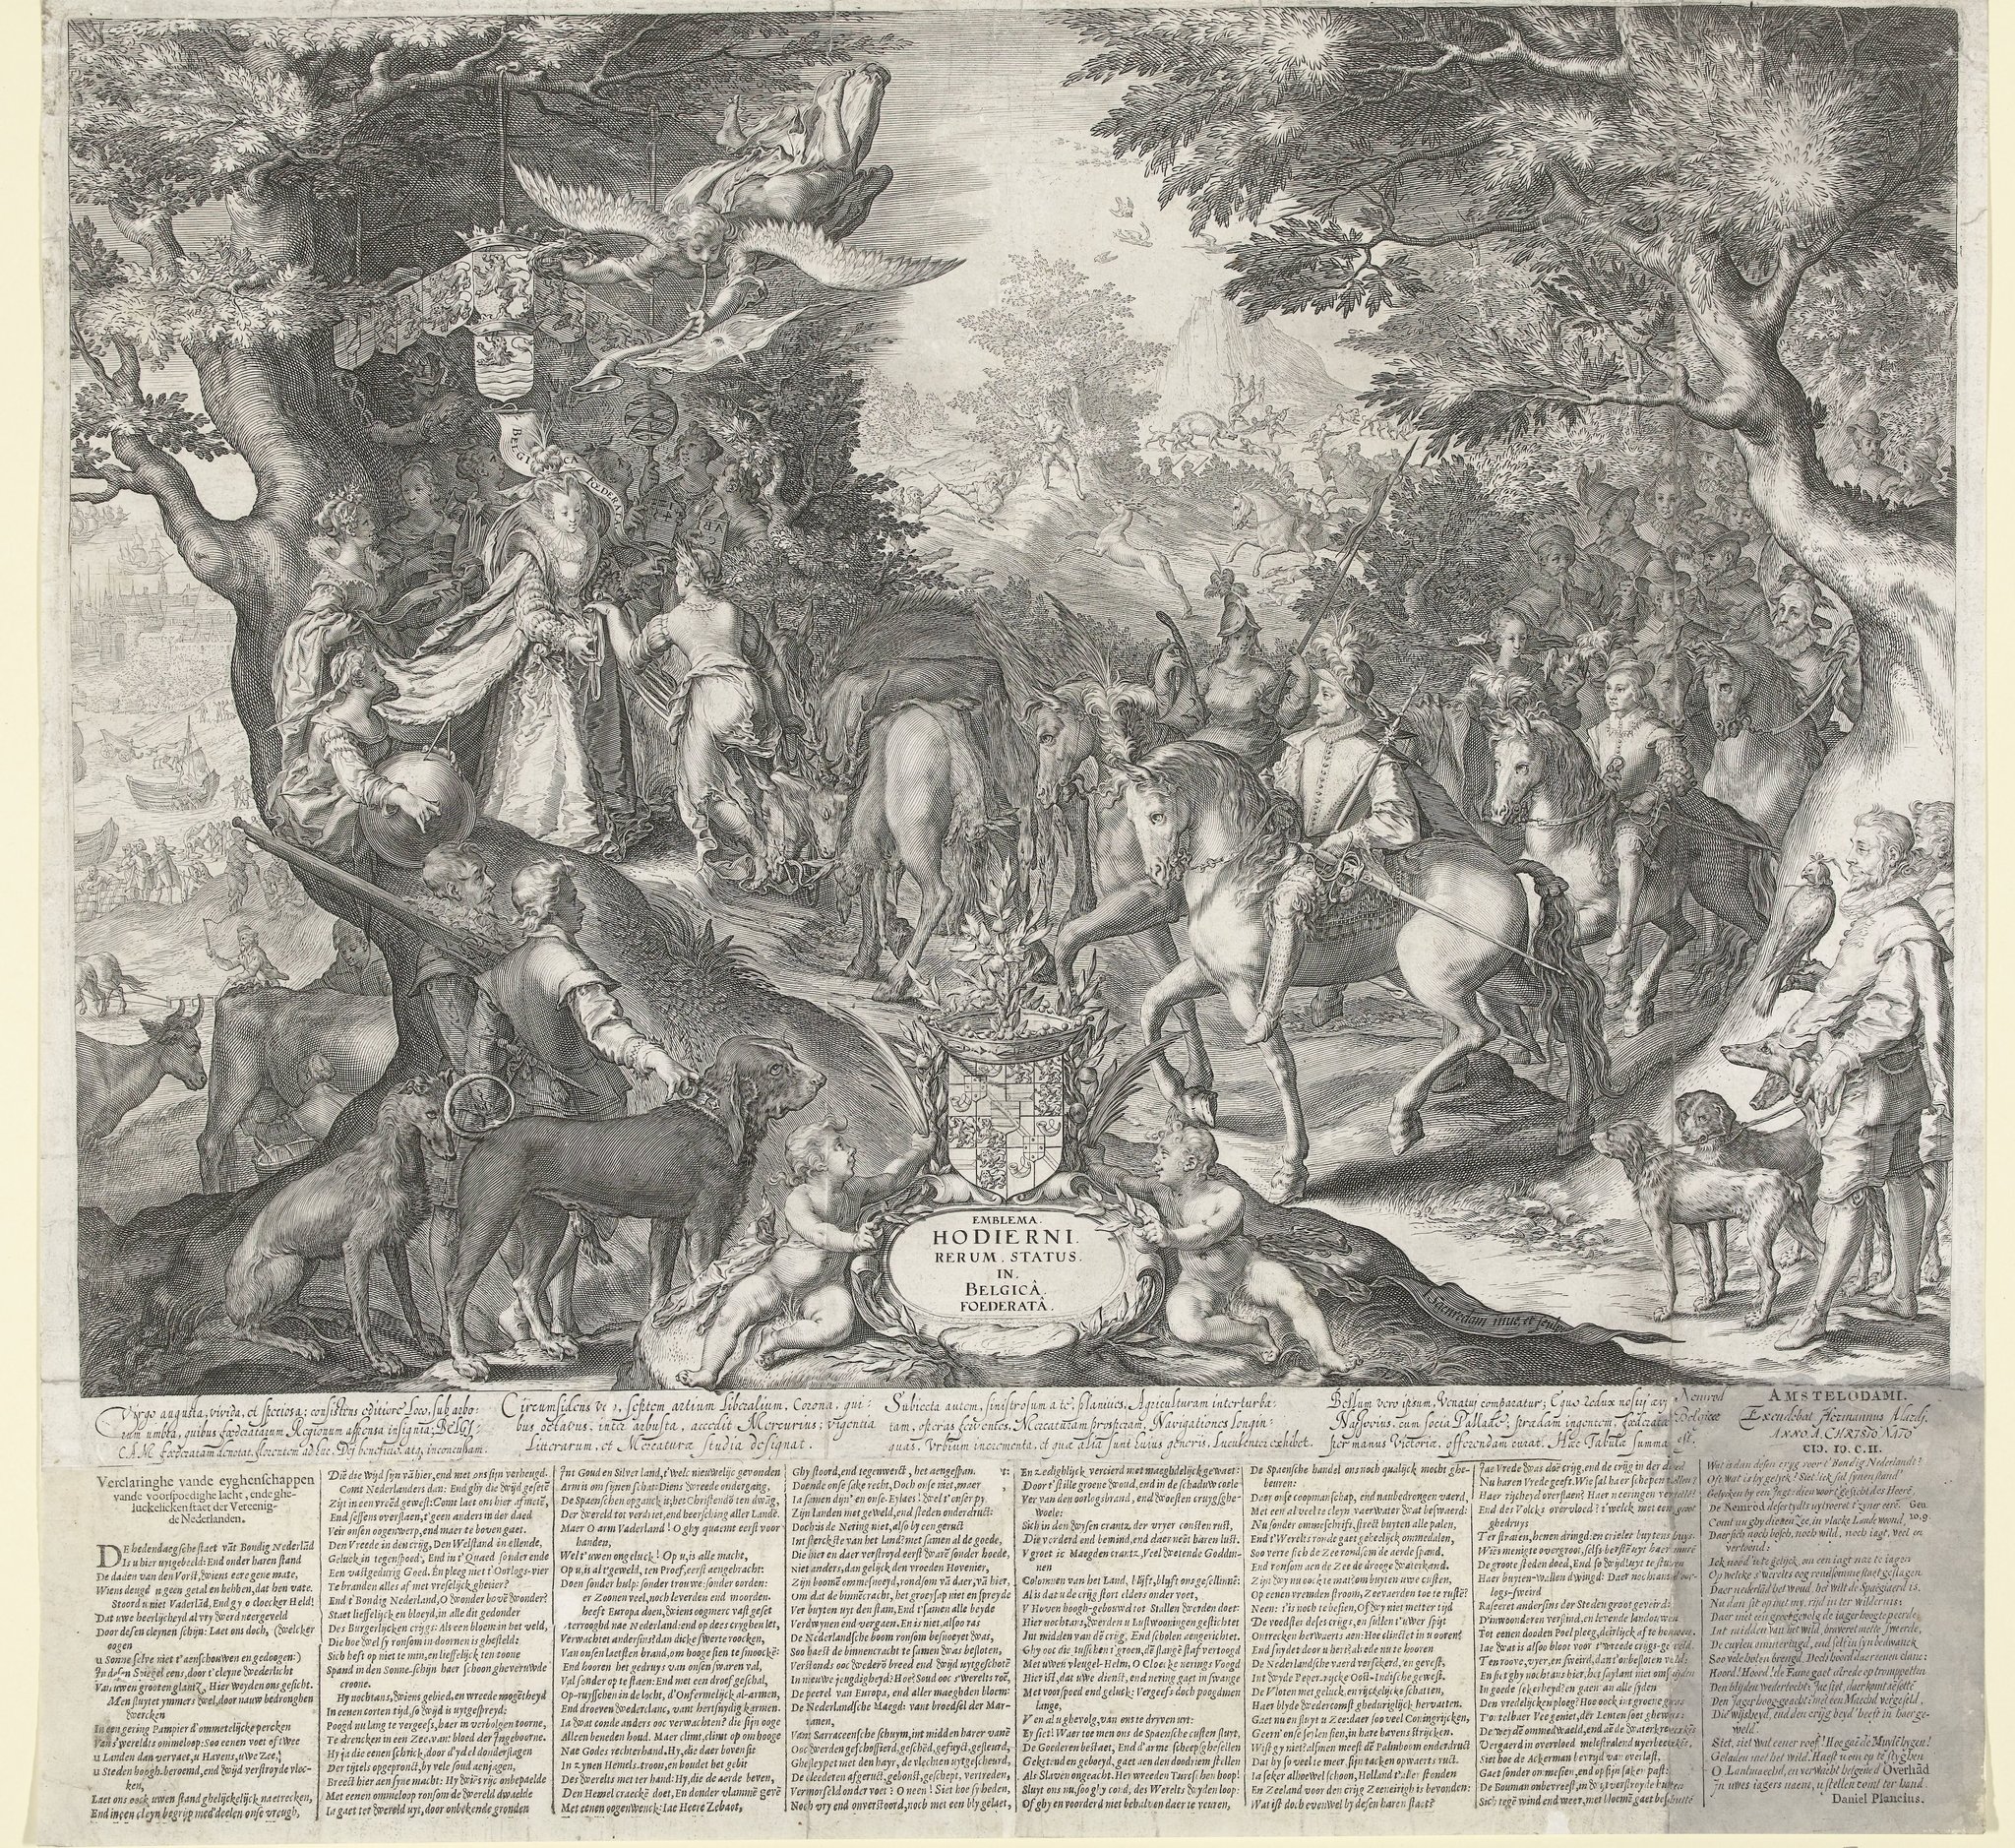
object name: propagandaprent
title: Emblema Hodierni rerum status in Belgica foederata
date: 1602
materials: paper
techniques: engraving, letterpress printing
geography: northern netherlands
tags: frederick henry (prince of orange), the hague, maurice (prince of orange), personifications of countries, nations, states, districts, etc., hunting, chase, netherlands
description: Allegorie op de bloeiende staat van de Republiek, 1602. Gezicht in het bos met prins Maurits aan het hoofd van een jachtpartij waarbij de opbrengsten van de jacht worden aangeboden aan de Nederlandse Maagd als personificatie van de verenigde Nederlanden. Rechts de stoet jagers waaronder Frederik Hendrik. De Nederlandse Maagd staat omringd door de personificaties van de vrije kunsten, Mercurius en de wapens van de provincies van de Republiek. Fama blaas op de bazuin. Op de voorgrond twee putti met het wapen van Maurits en de bloeiende oranjeboom. In het onderschrift van 4 verzen van 3 regels in het Latijn. Onderaan de prent vastgeplakt een apart gedrukte tekst van 8 kolommen in het Nederlands.